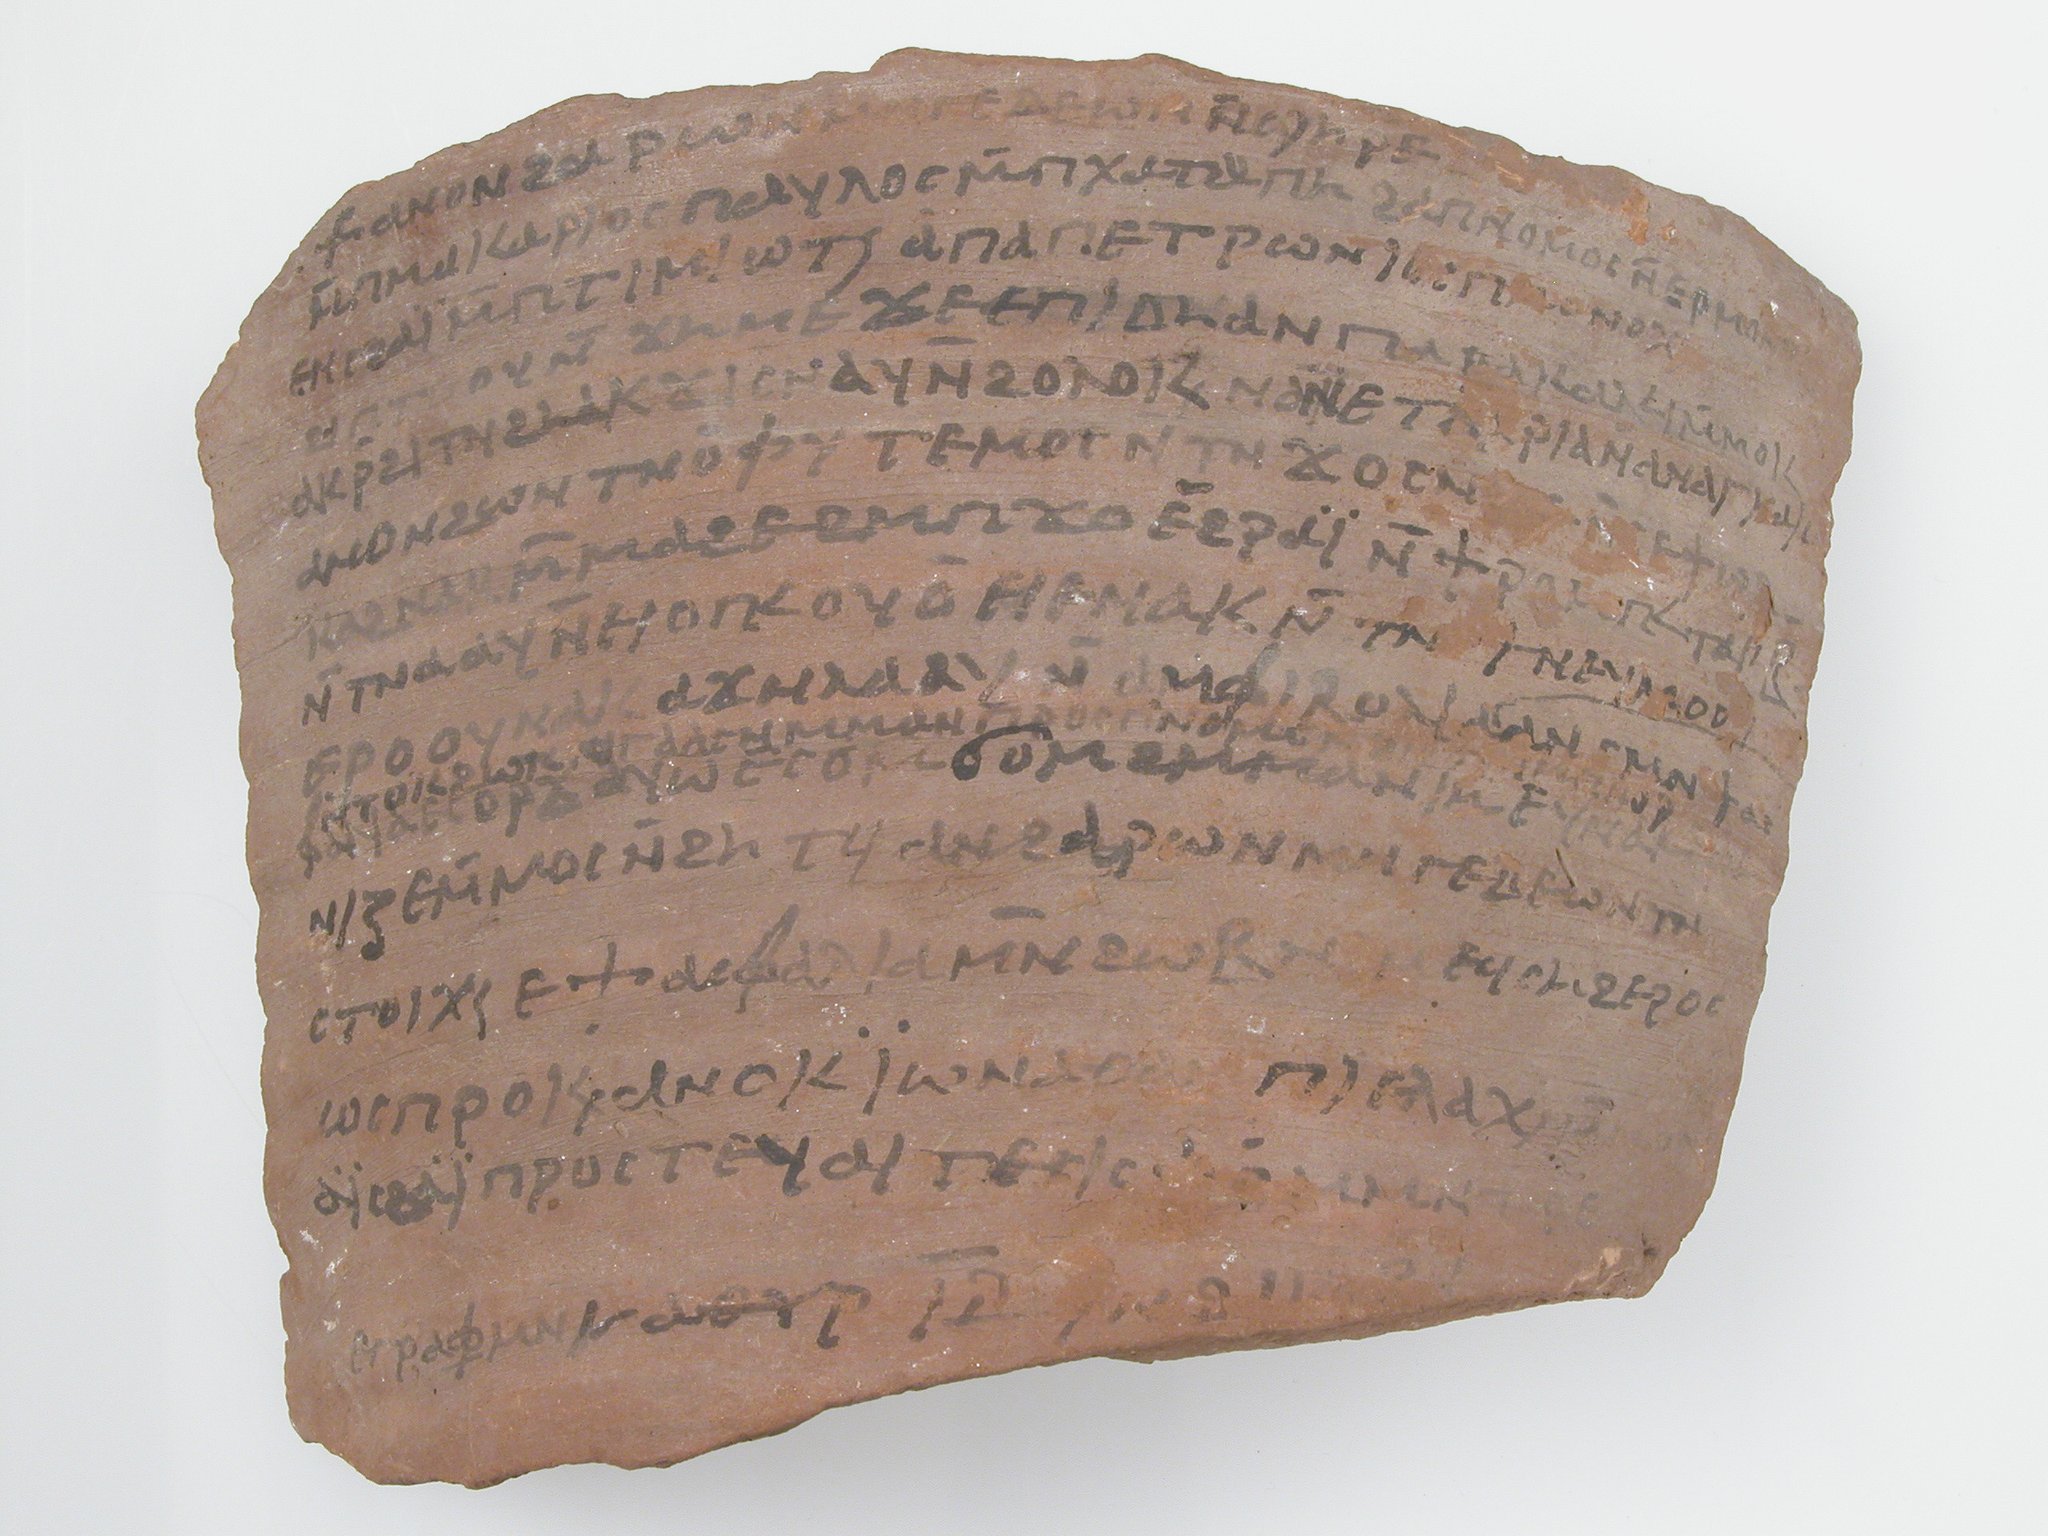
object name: ostrakon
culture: coptic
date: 601-700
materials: ink, pottery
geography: egypt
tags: documents